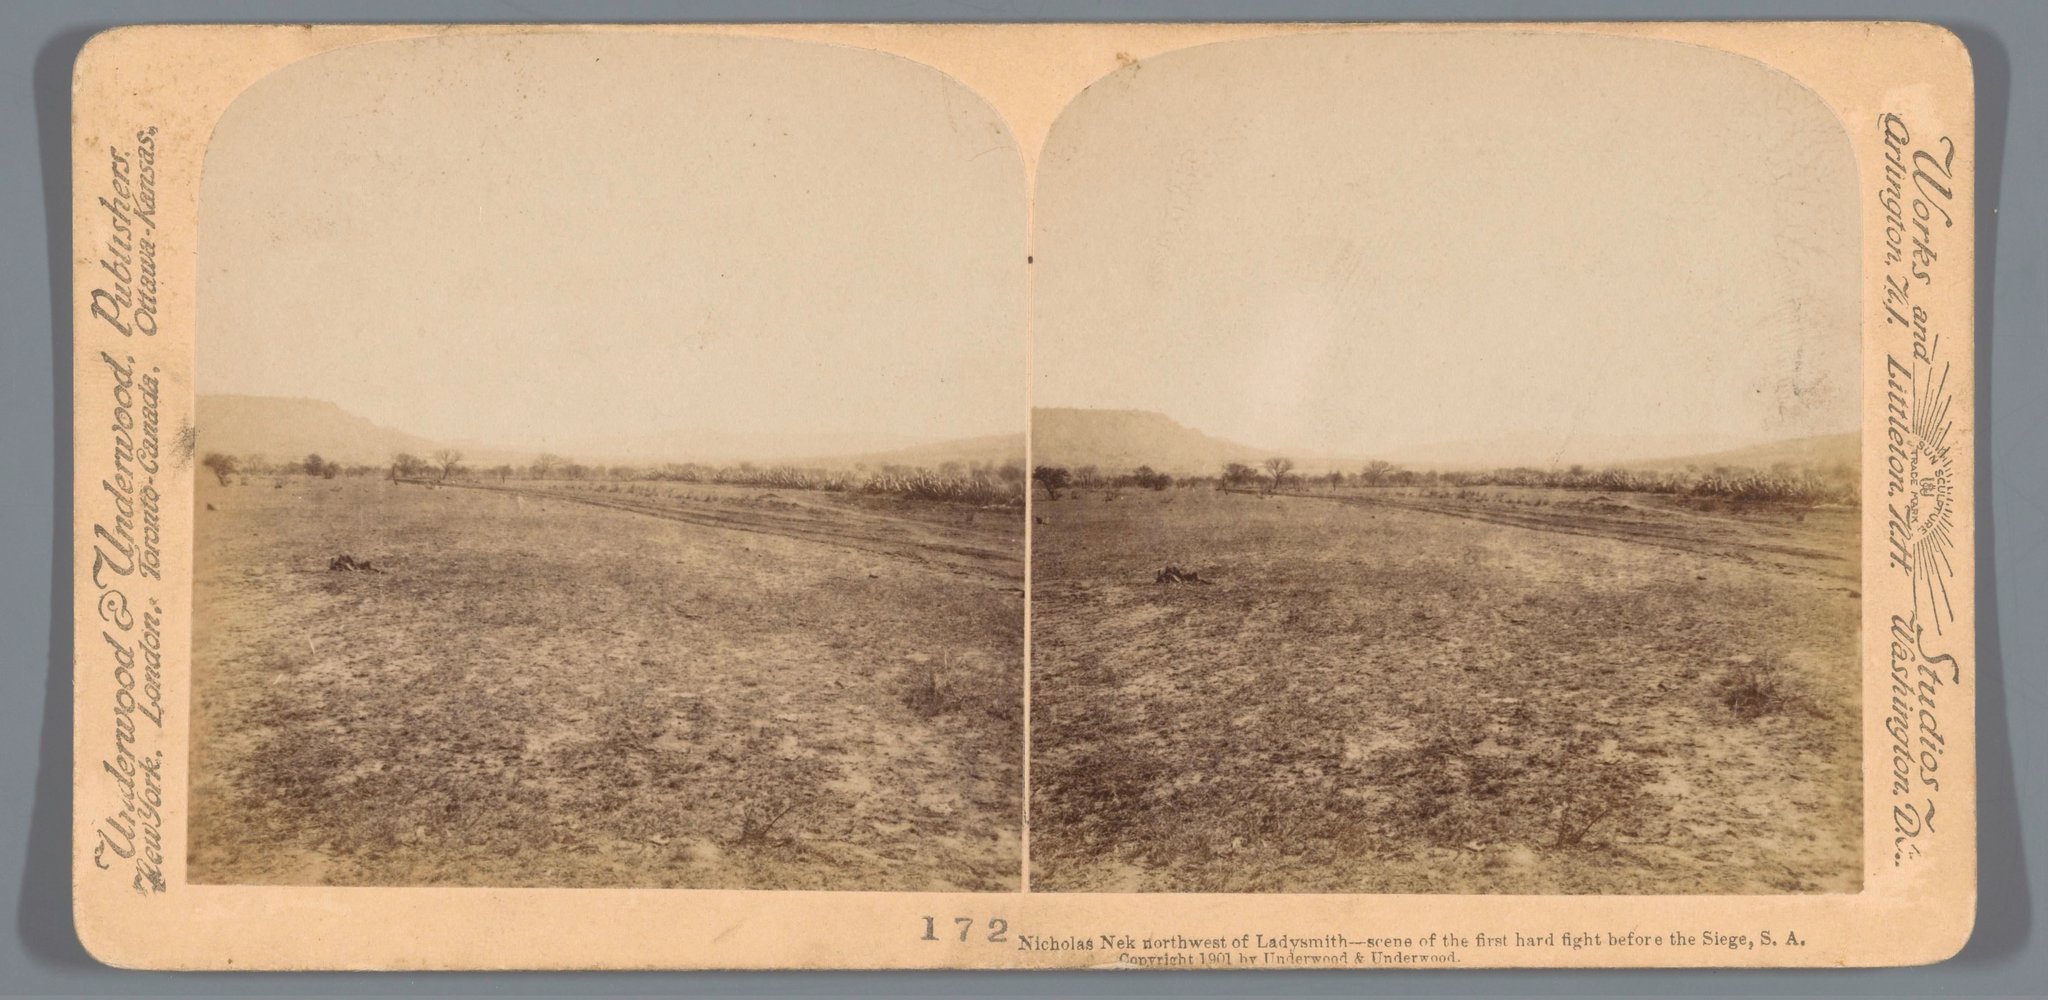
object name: stereograph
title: Gezicht op een vlakte bij Ladysmith waar in de Tweede Boerenoorlog is gevochten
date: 1901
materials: cardboard, photographic support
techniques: albumen print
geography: south africa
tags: landscapes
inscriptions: name: ‘Works and Studios Sun Sculpture trade mark Arlington N.J. Littleton N.H. Washington D.C.’, number: ‘172’